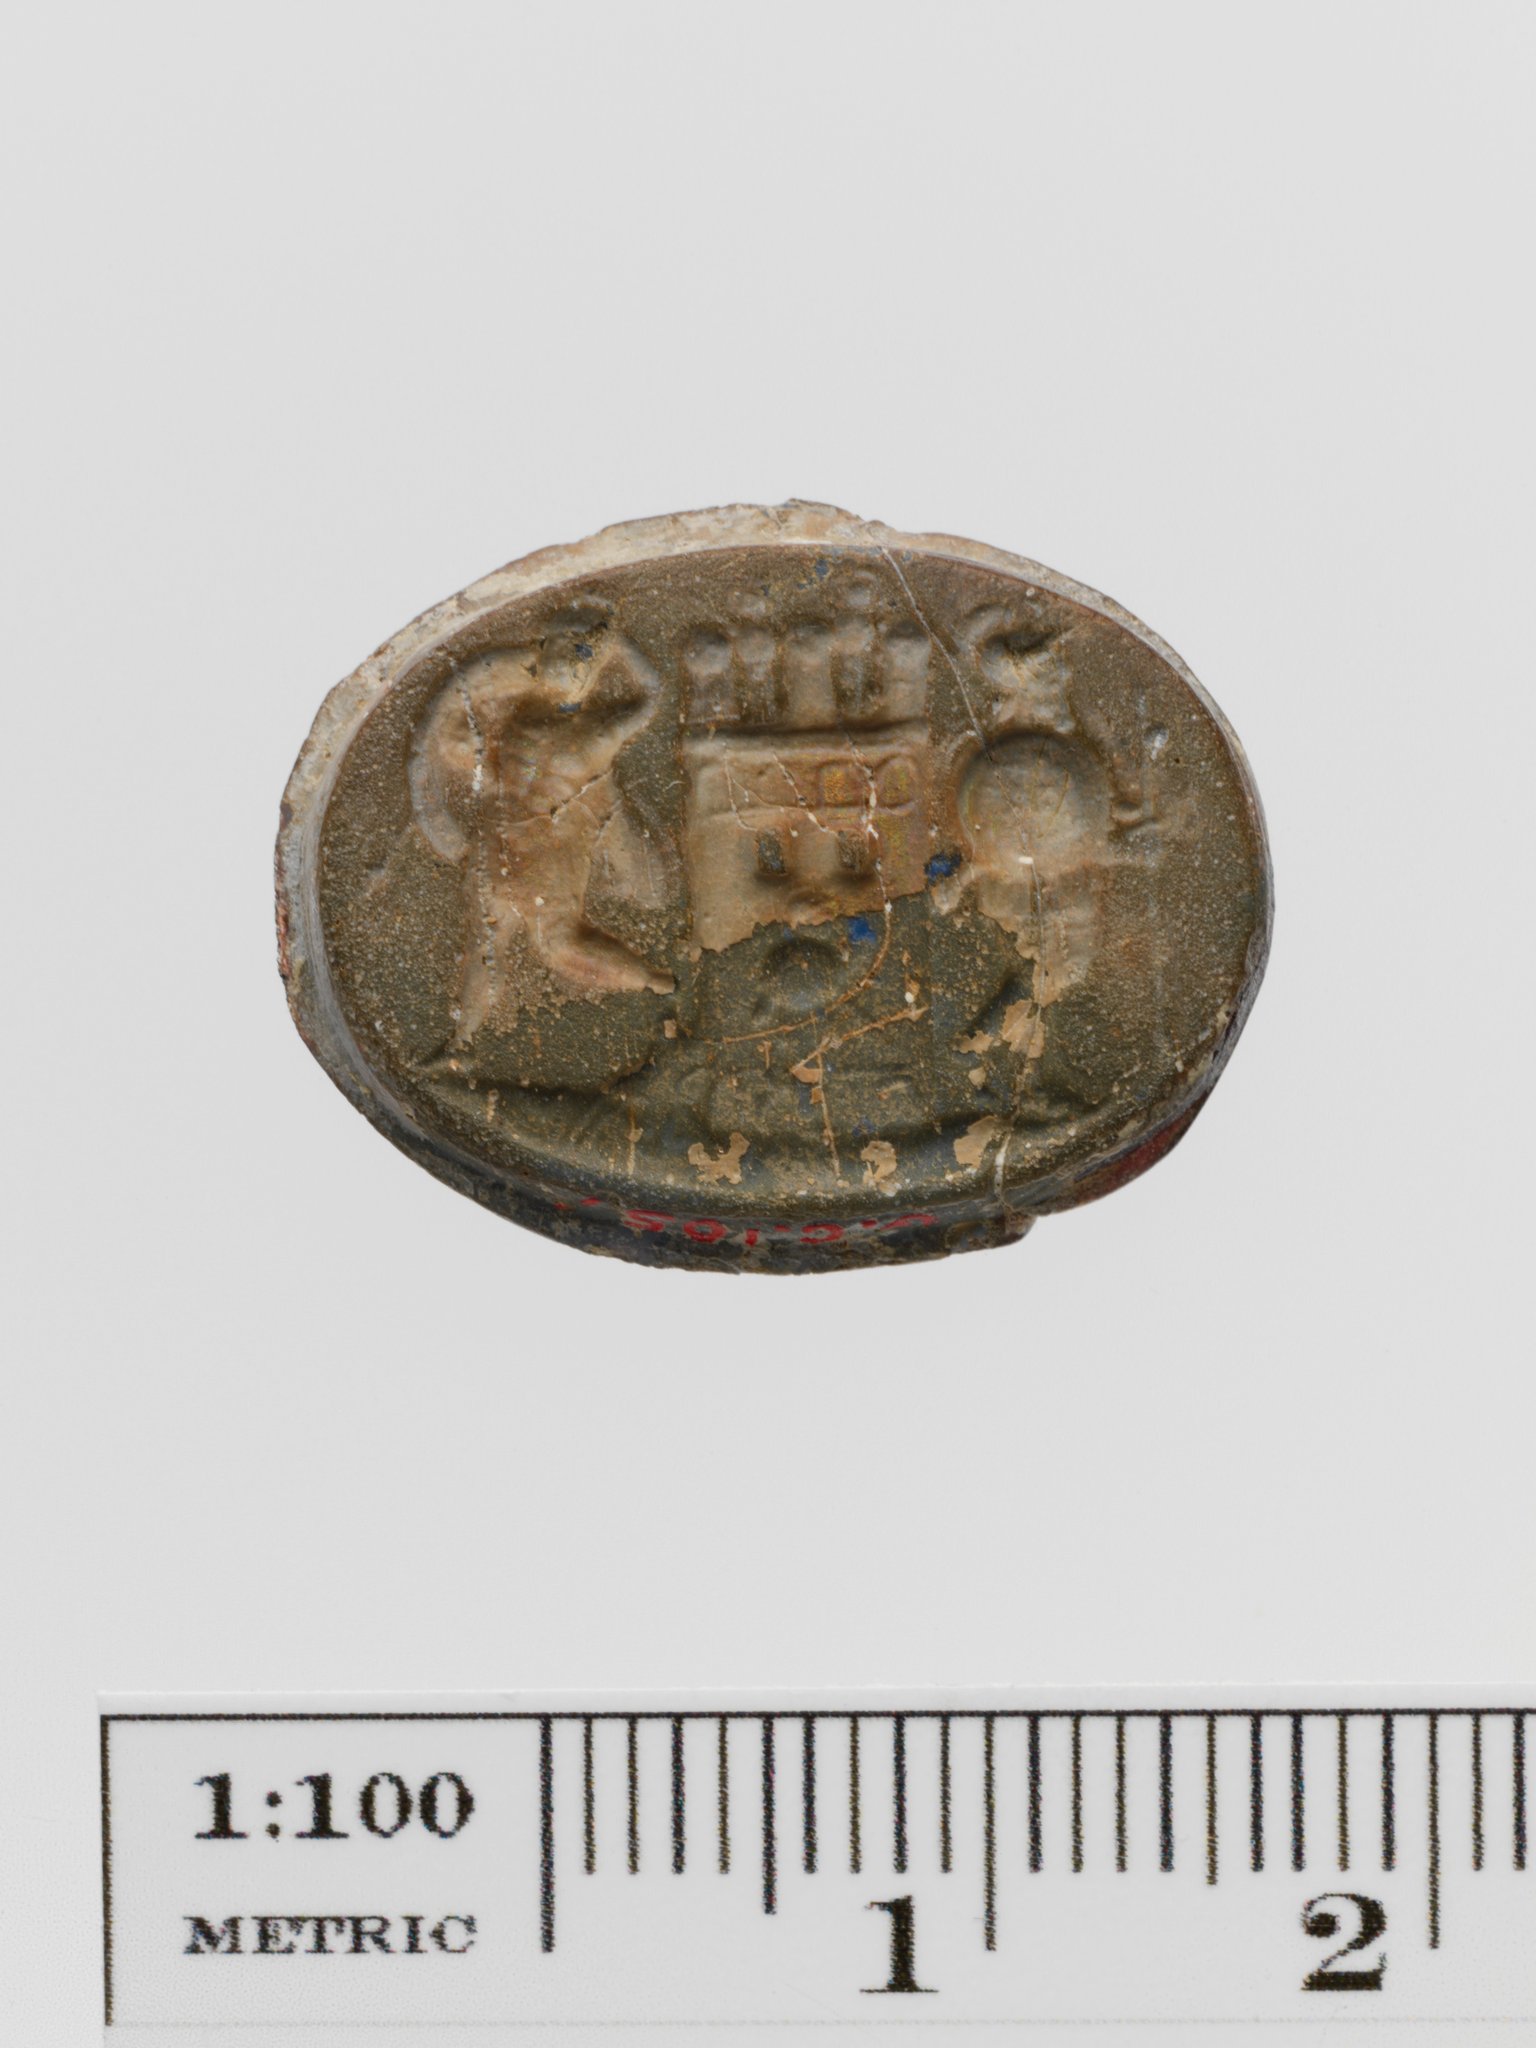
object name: intaglio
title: Blue glass ring stone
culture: italic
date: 300-101 BCE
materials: glass, paste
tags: soldiers